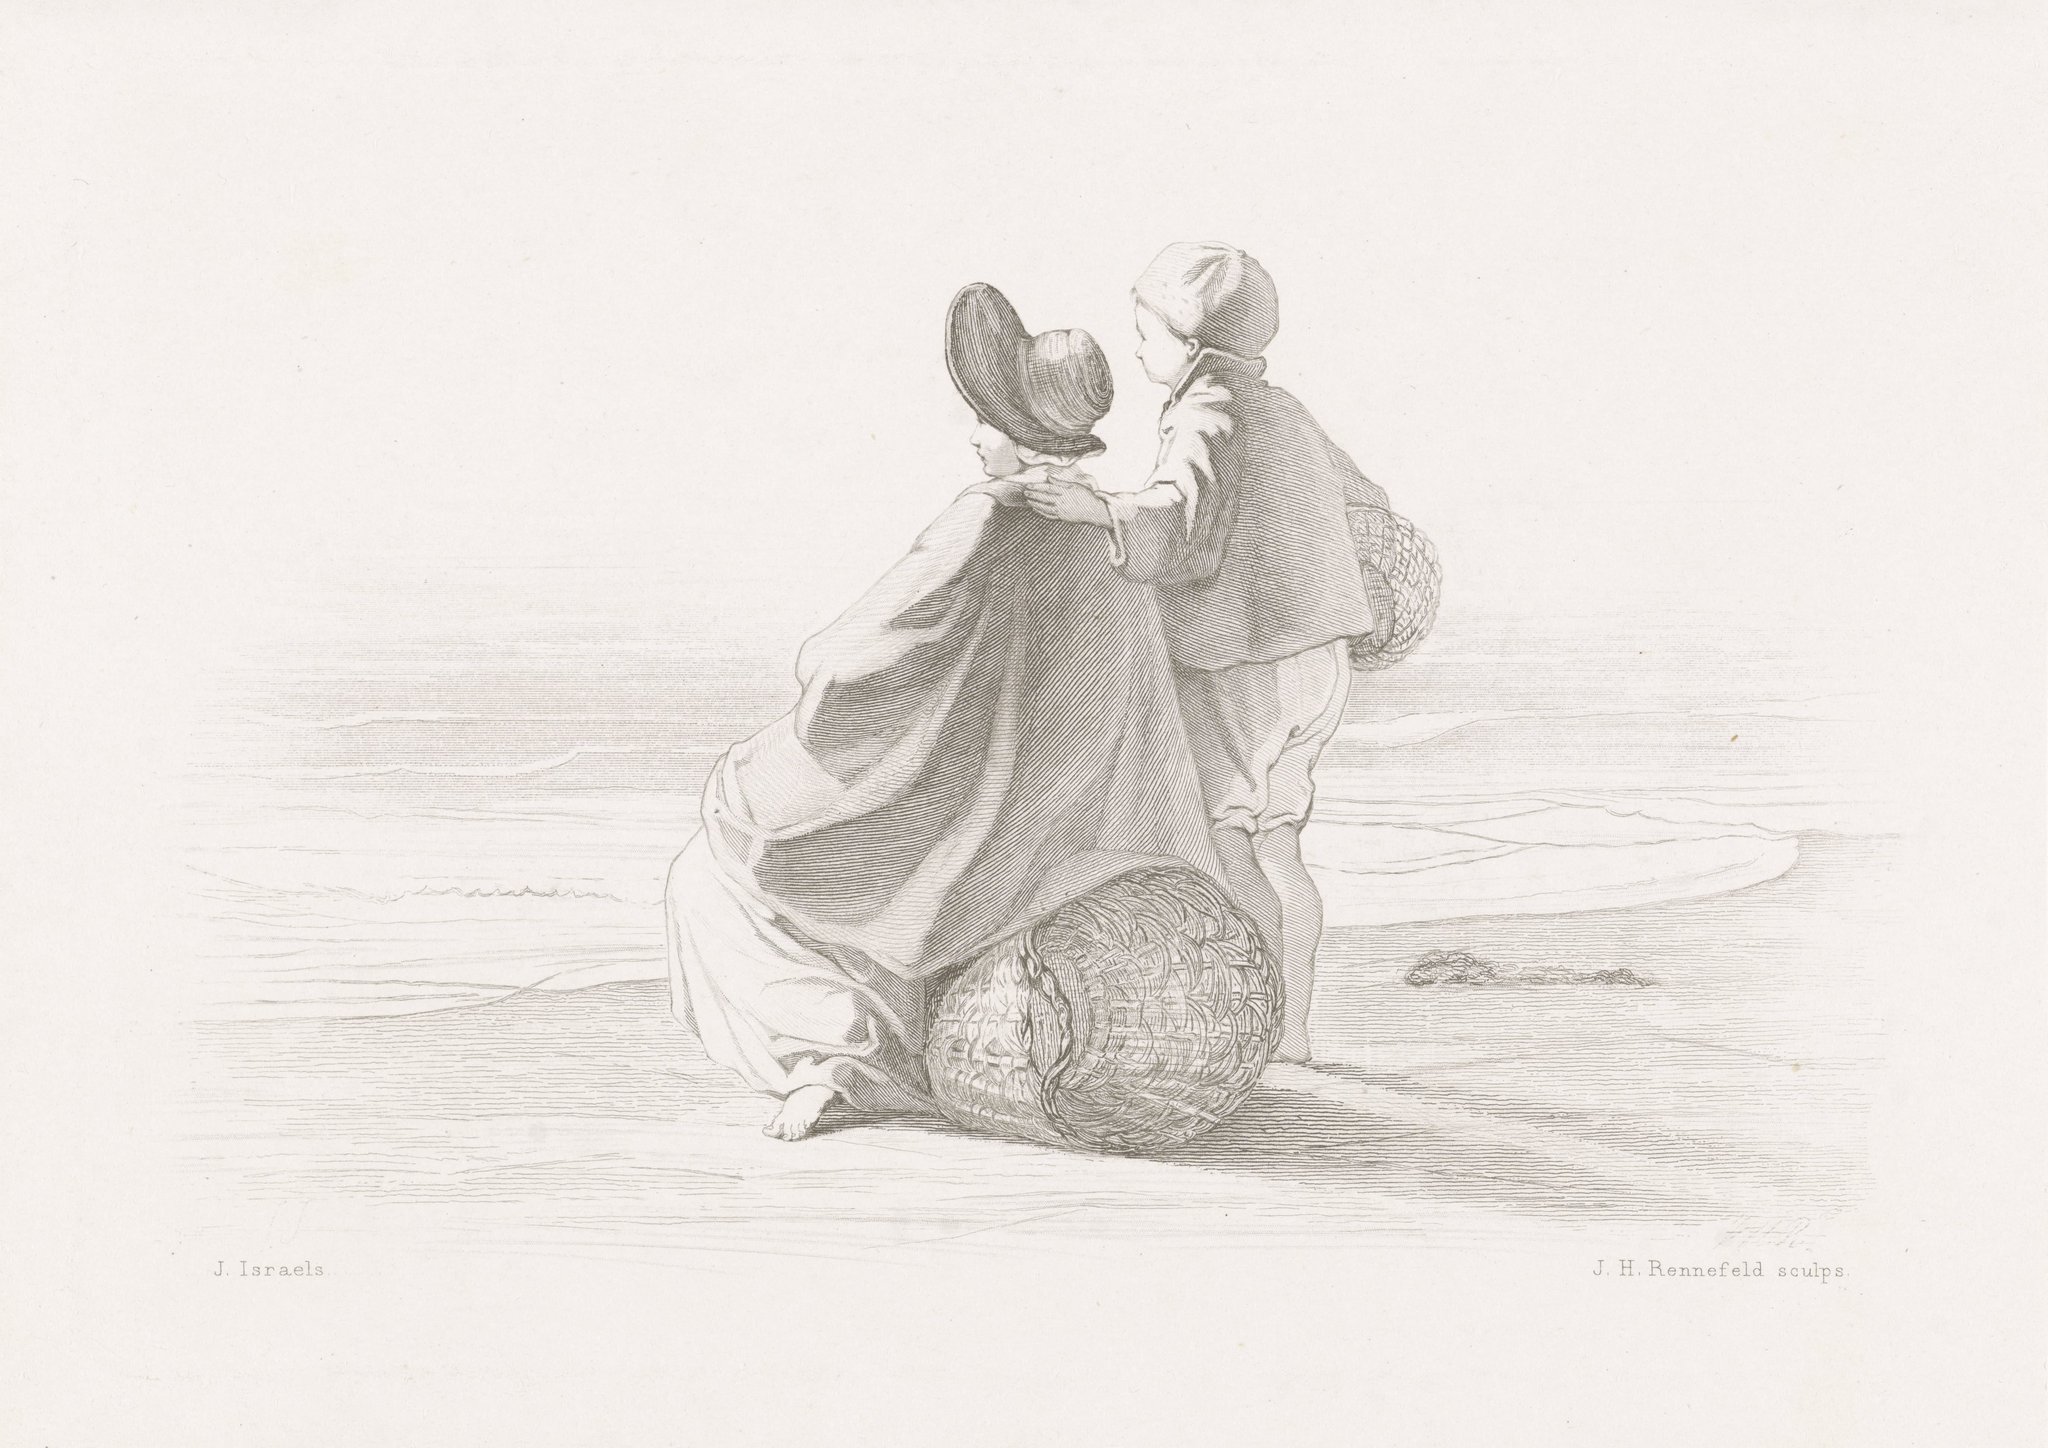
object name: print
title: Uitreis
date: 1861-1872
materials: paper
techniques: roulette, engraving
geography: amsterdam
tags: mother and son(s) (family group), in or beside the water (on the beach)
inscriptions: collector's mark: Lugt 2228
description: Aan de vloedlijn kijken een vrouw en een kind in de richting van de zee. De vrouw zit op een omgekeerde mand en het kind heeft een mand onder de arm. De prent maakt deel uit van de serie prenten 'De kinderen der zee'.